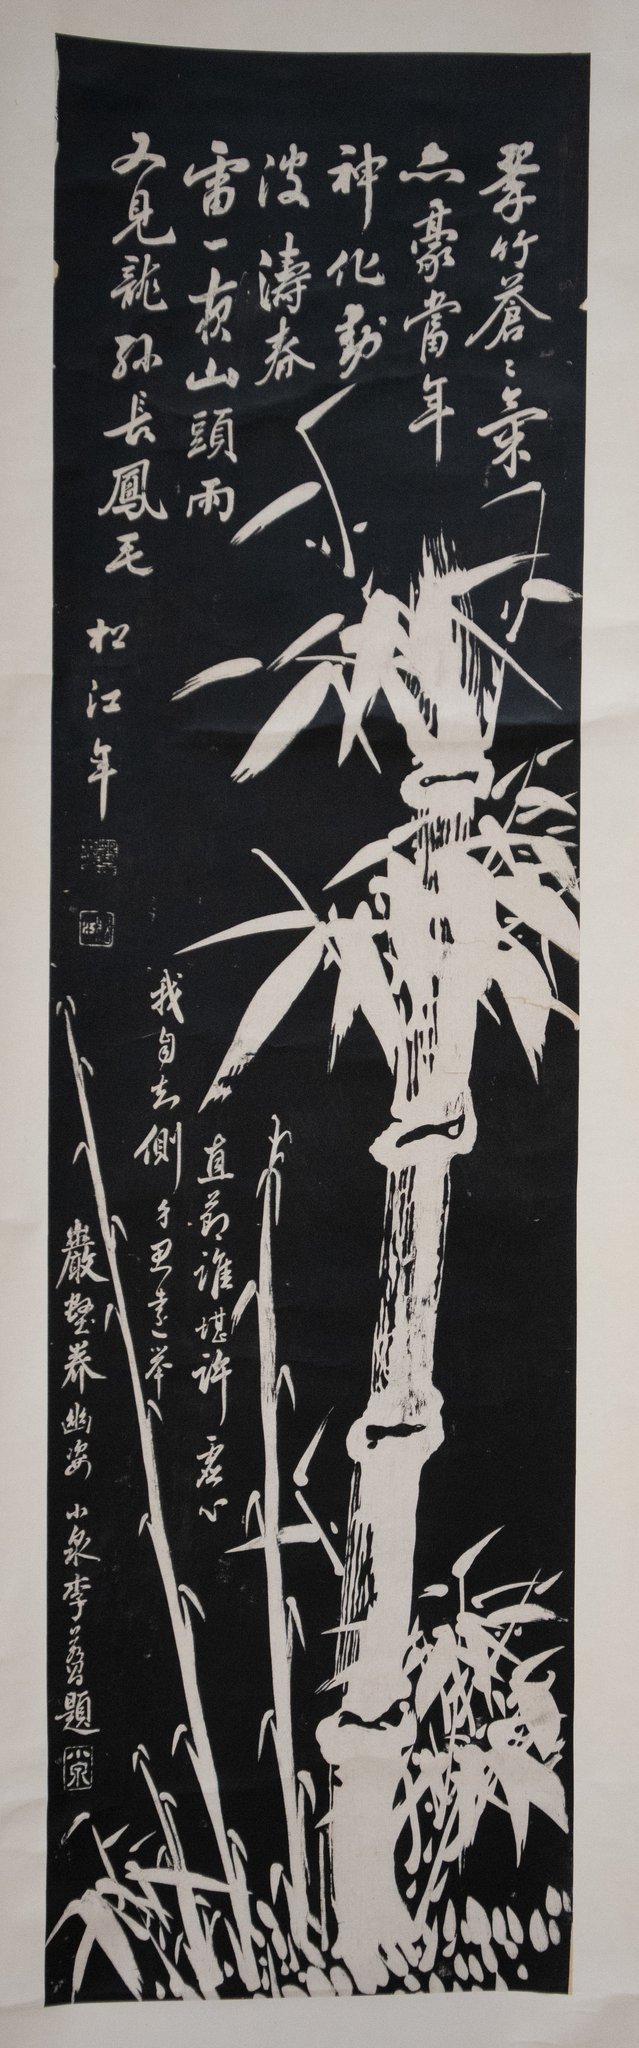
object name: print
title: Bamboo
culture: chinese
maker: kuang xü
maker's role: artist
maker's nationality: chinese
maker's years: 1874-1909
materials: ink, paper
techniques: polychrome, woodblock print